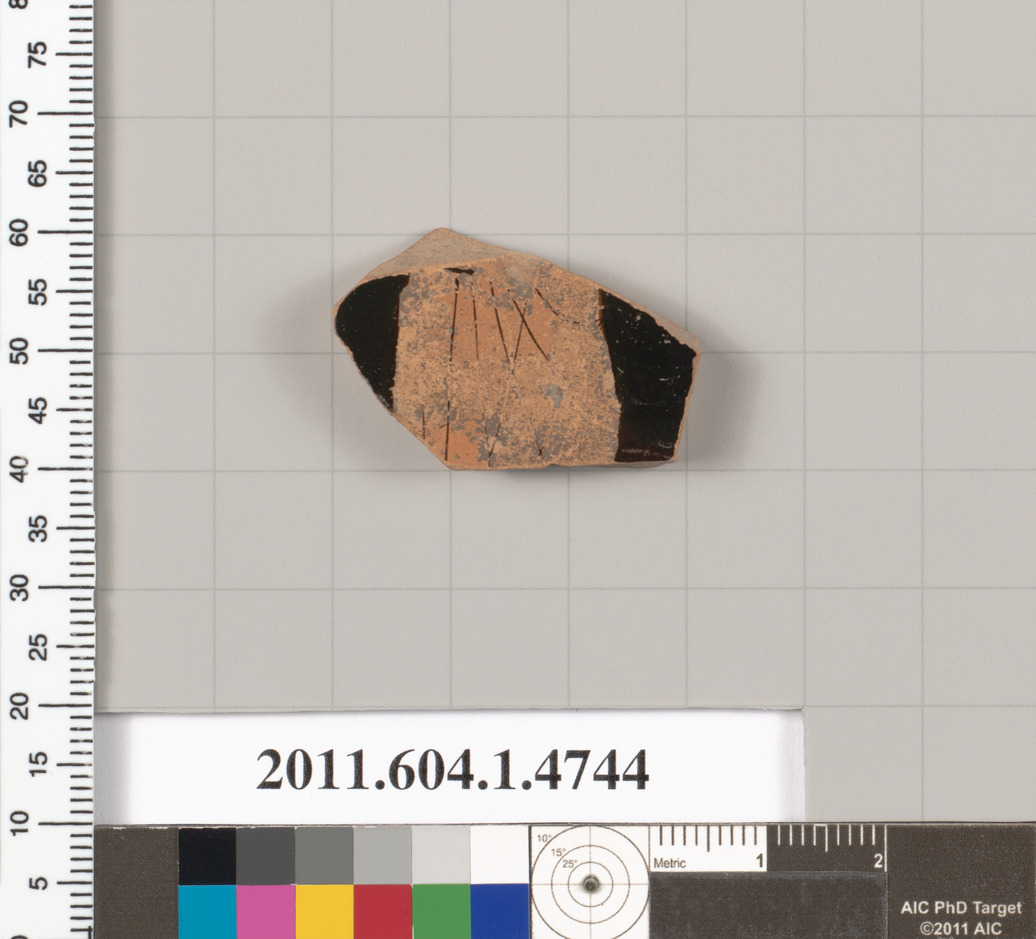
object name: kylix fragment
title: Terracotta fragment of a kylix (drinking cup)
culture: greek, attic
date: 475-451 BCE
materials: terracotta